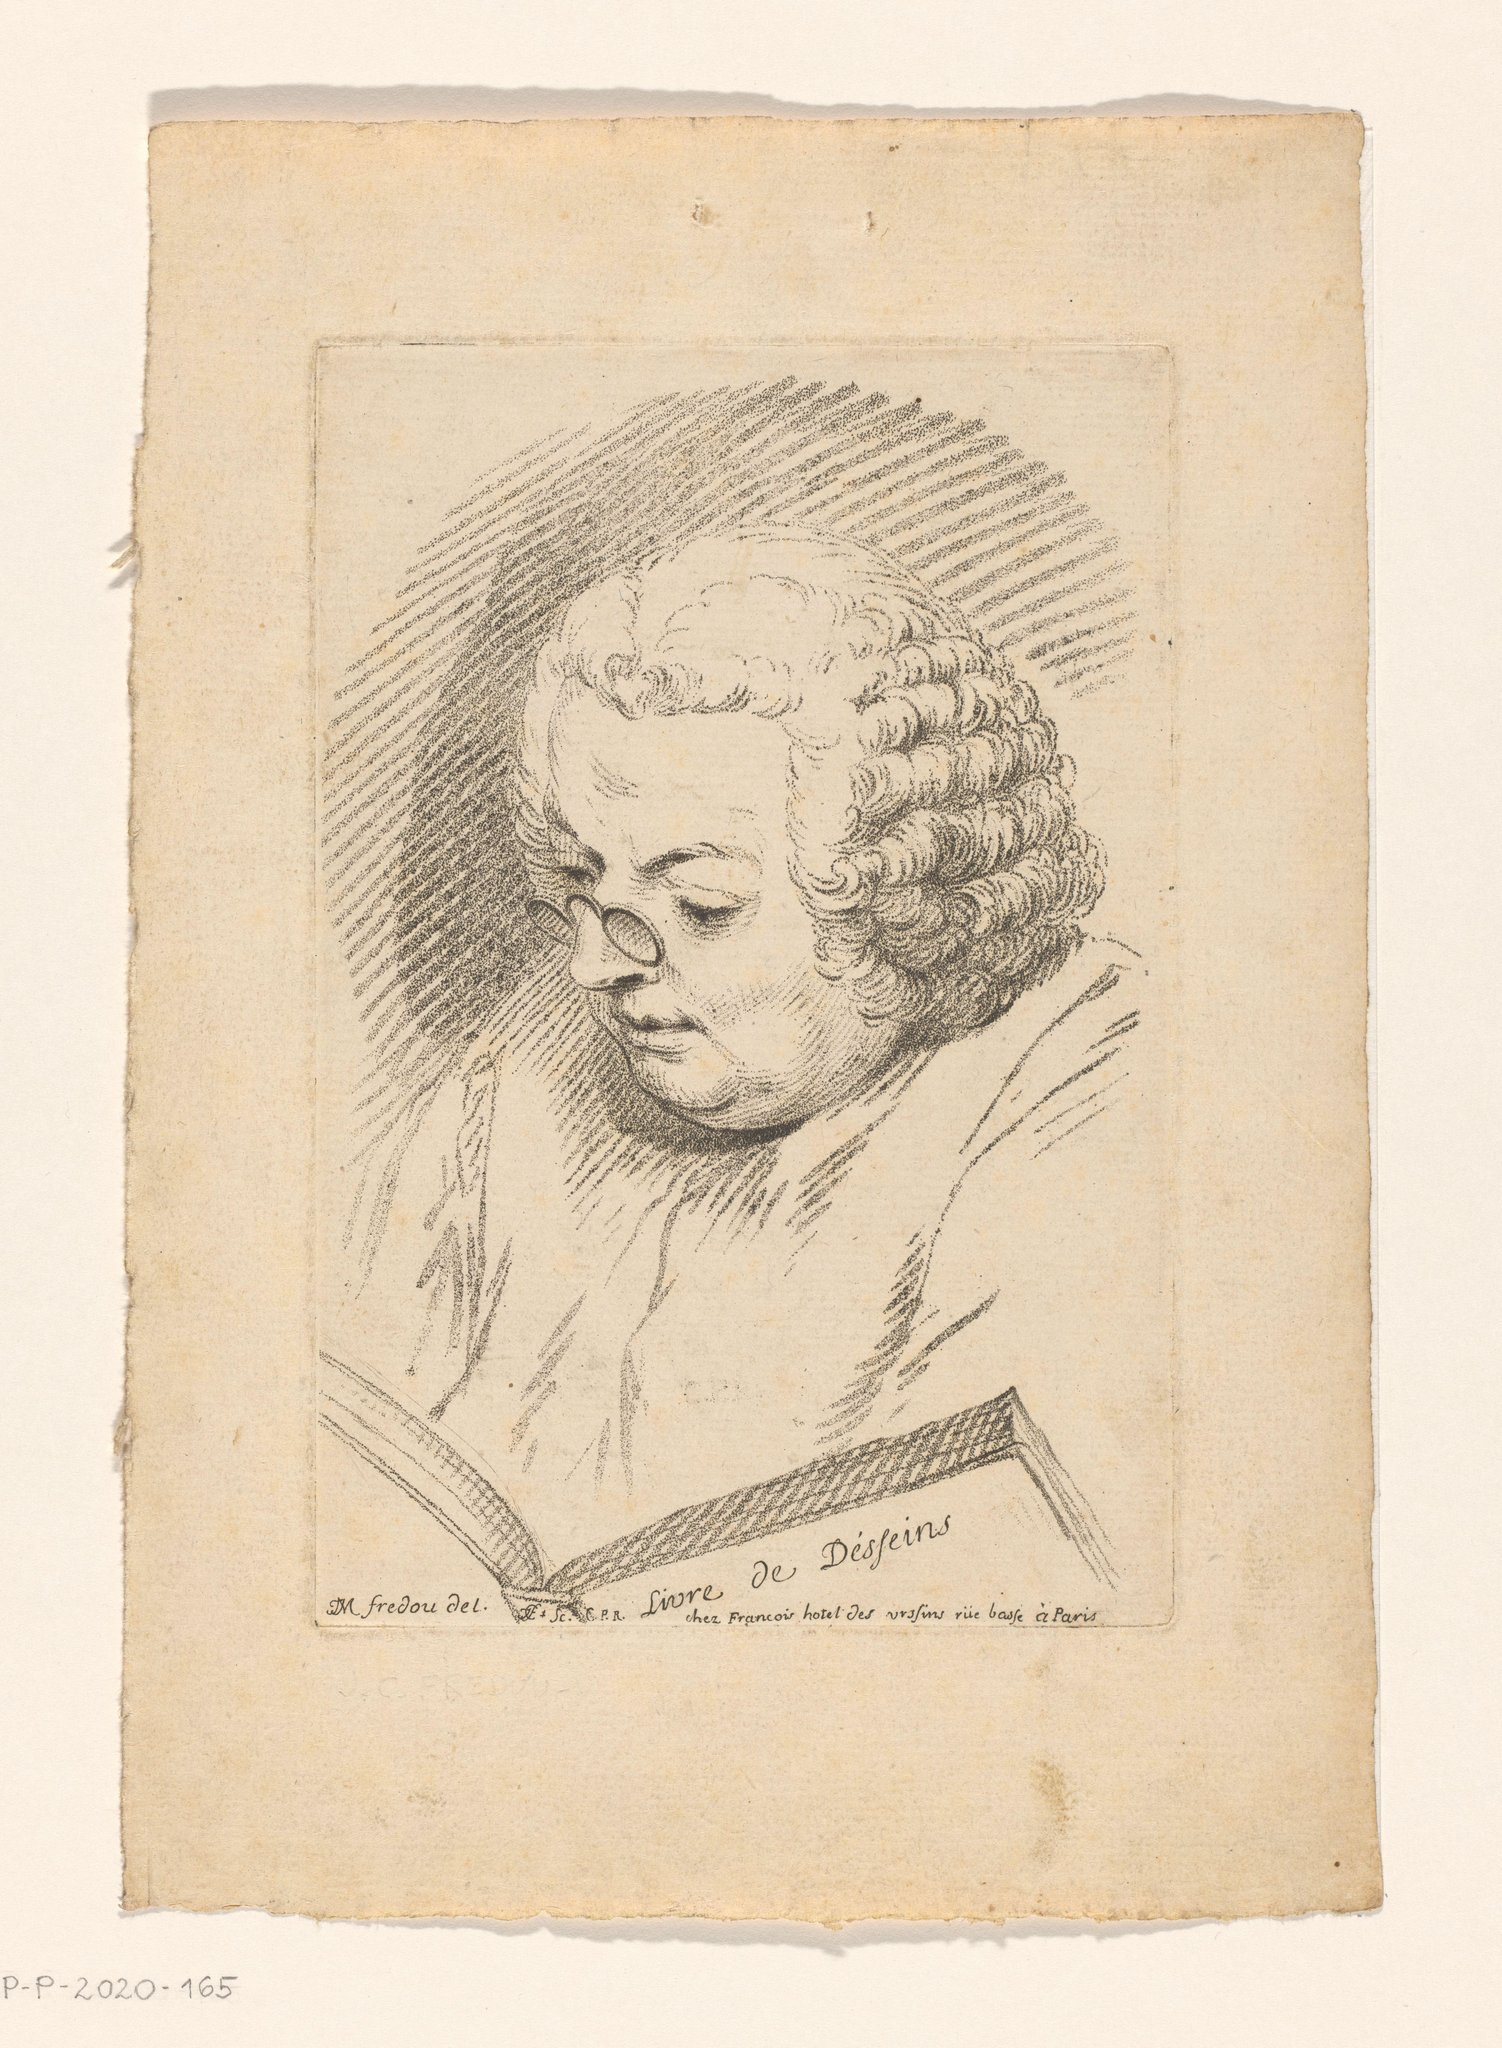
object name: print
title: Portret van de verzamelaar Jacques André Portail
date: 1750-1769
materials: paper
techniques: printmaking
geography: paris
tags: draughtsman, jacques andré portail, drawing, sketch, historical persons, art collector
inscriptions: collector's mark: Lugt 2228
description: Portretbuste van de verzamelaar Jacques André Portail met bril kijkend in een album met tekeningen ('Livre de desseins'').